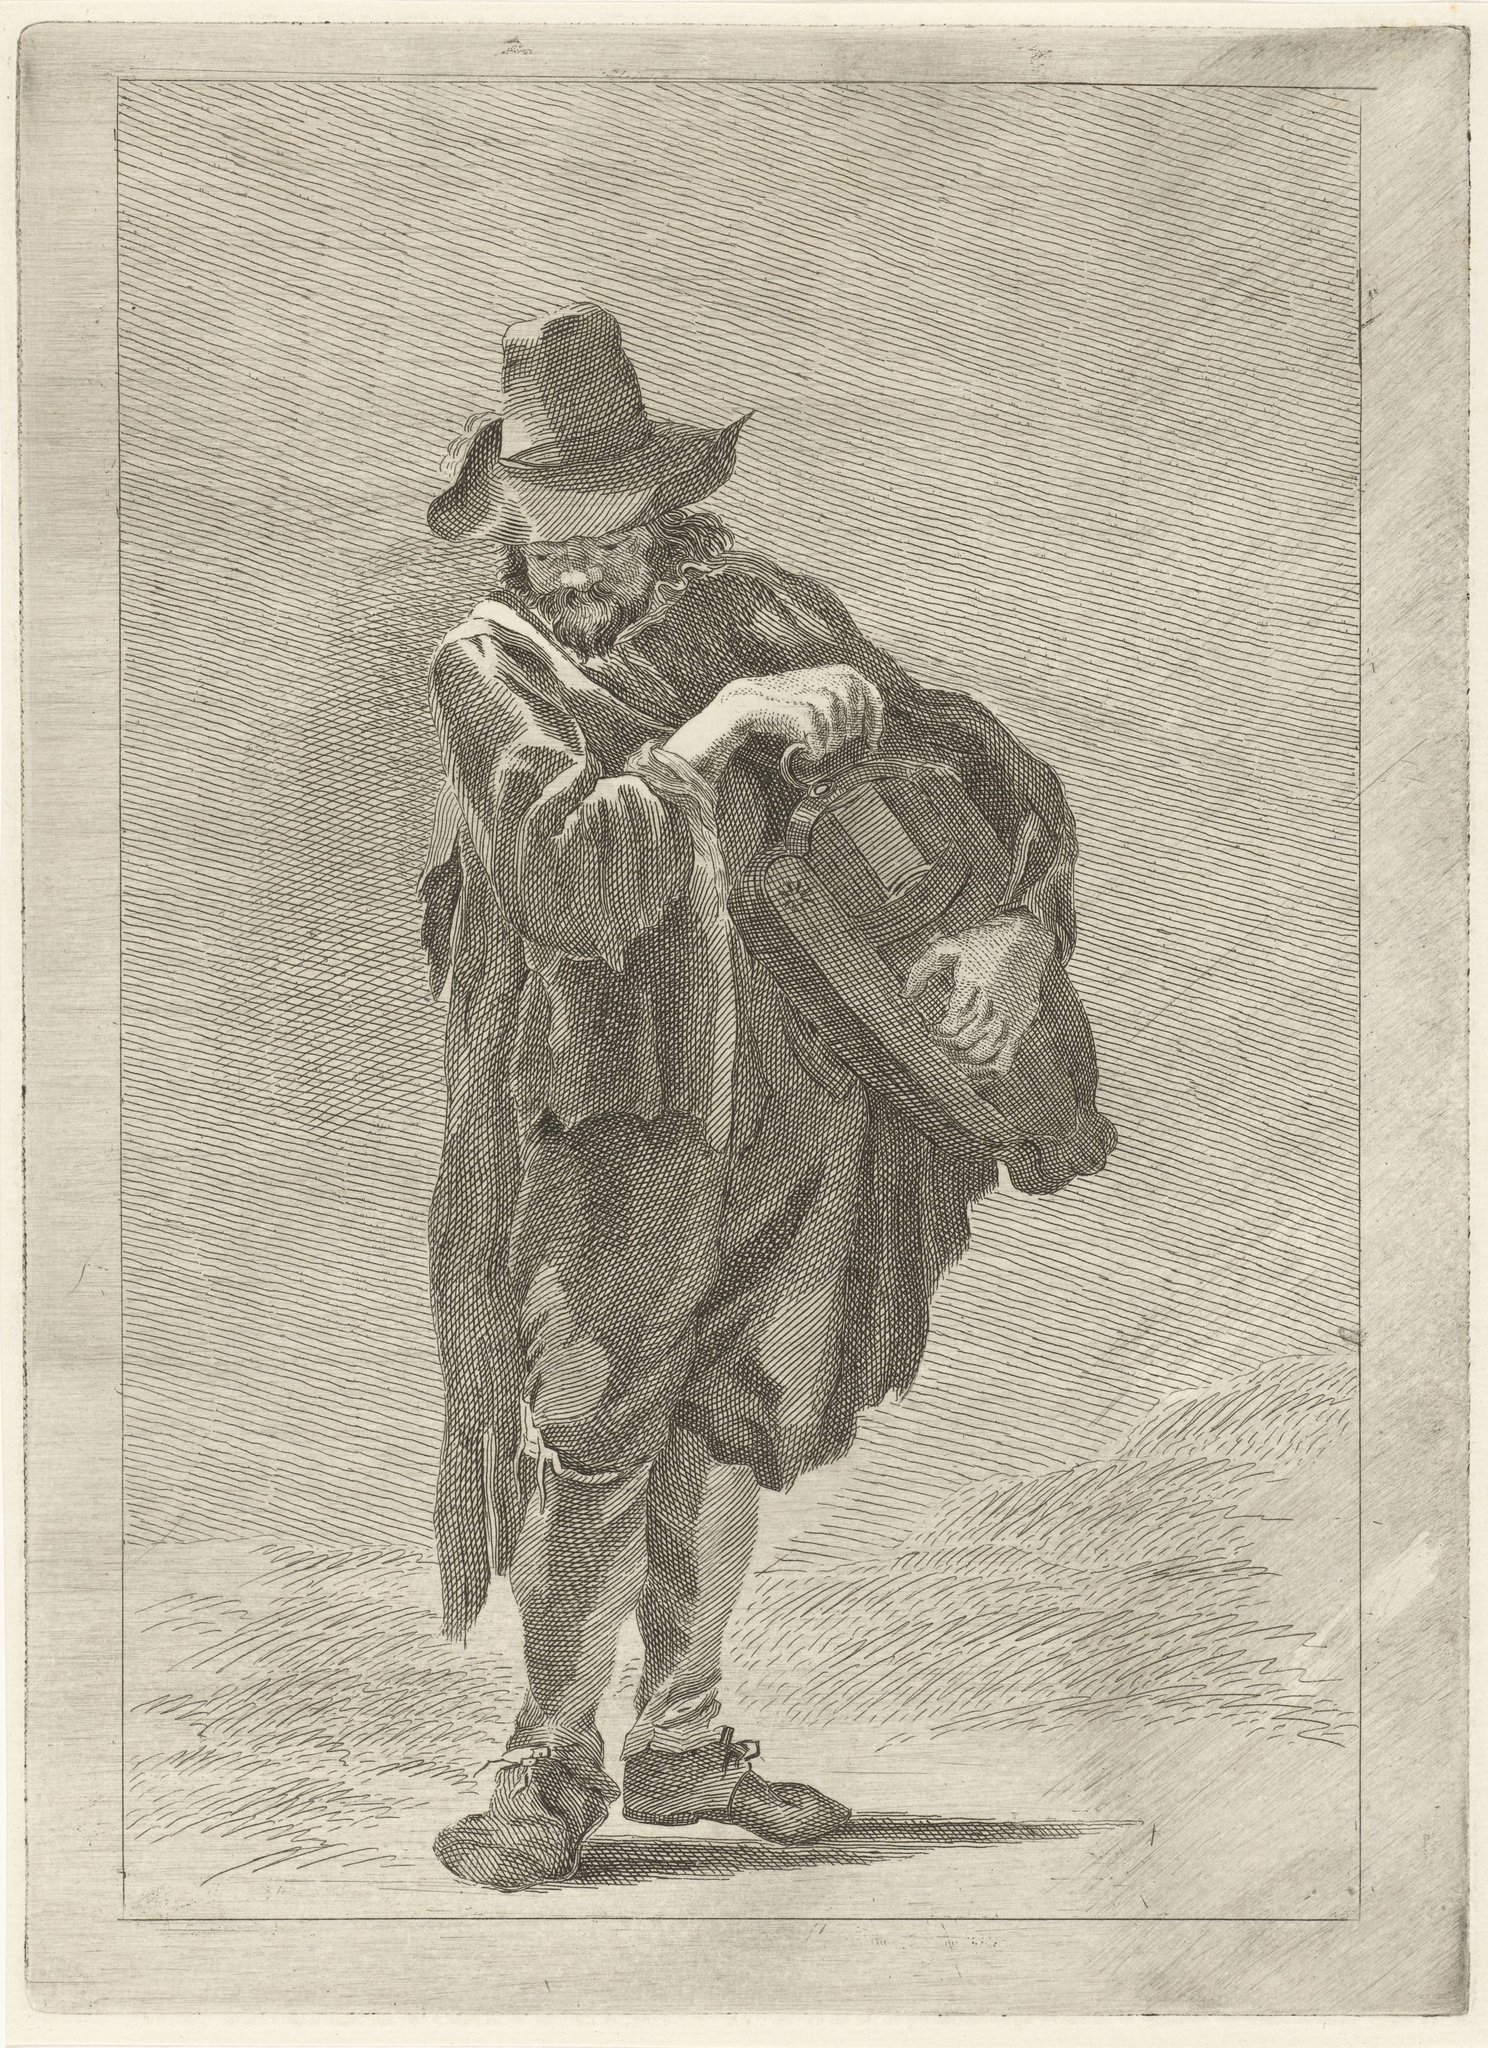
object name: print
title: Liereman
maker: pieter de mare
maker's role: print maker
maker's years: 1758-1796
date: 1768-1796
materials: paper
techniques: etching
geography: amsterdam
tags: hurdy-gurdy player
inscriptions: collector's mark: Lugt 240